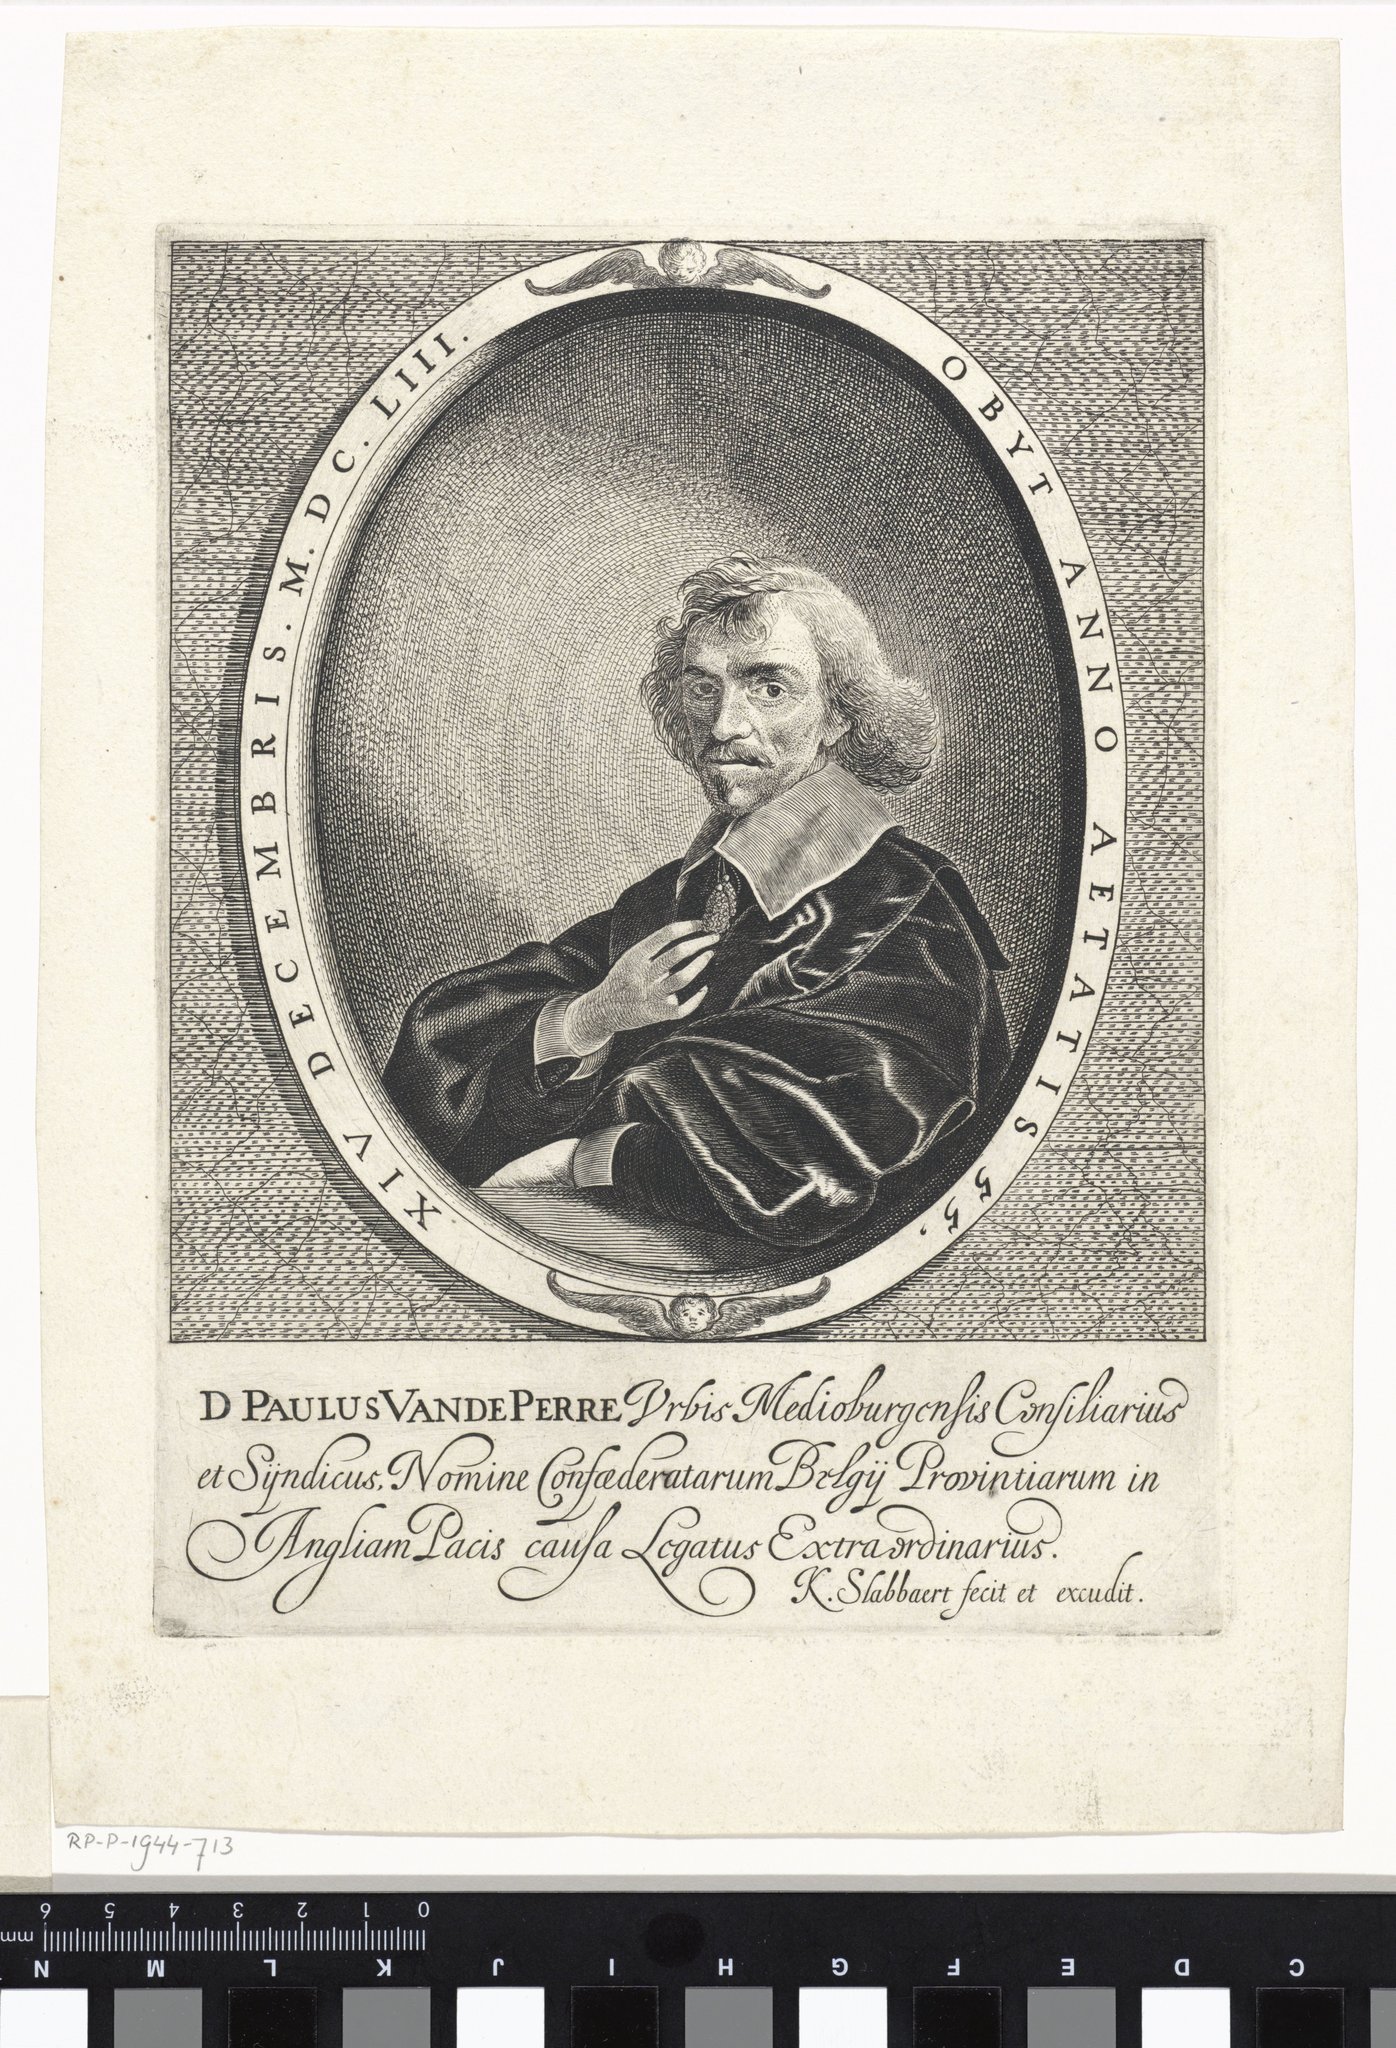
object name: print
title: Portret van Paulus van der Perre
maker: karel slabbaert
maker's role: draughtsman, painter, print maker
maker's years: 1618-1654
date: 1653-1654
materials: paper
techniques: engraving, etching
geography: middelburg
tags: london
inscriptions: collector's mark: Lugt 2228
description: Portret van de diplomaat Paulus van der Perre. Rondom zijn portret zijn sterfdatum. Onder de prent vier regels in het Latijn met zijn naam en enkele van de functies die hij bekleedde.